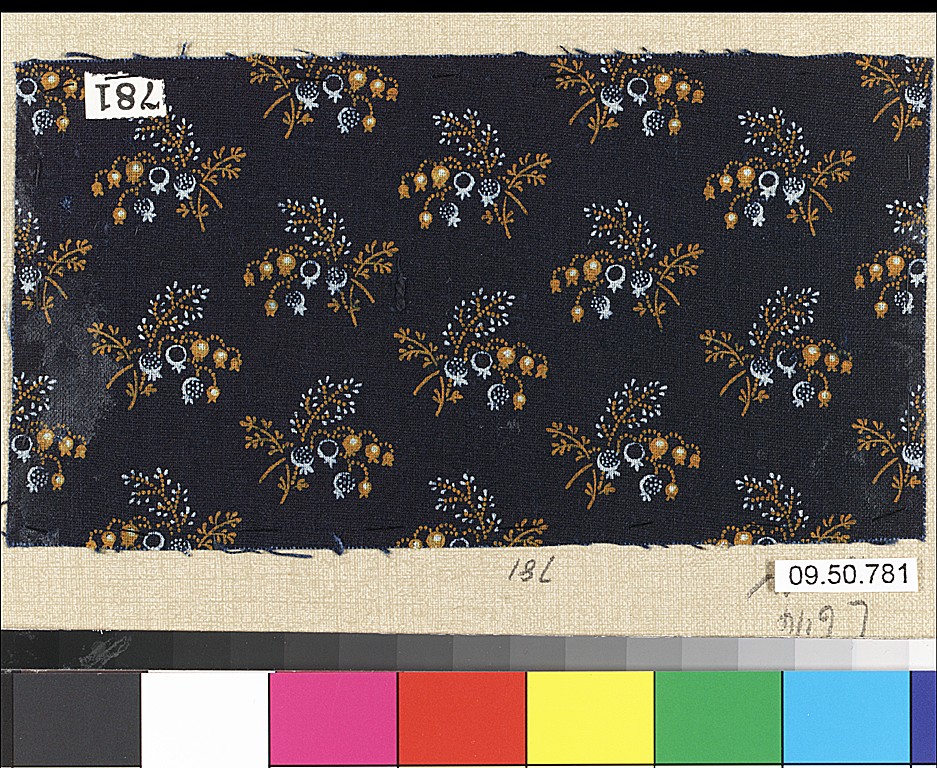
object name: piece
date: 1801-1900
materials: cotton